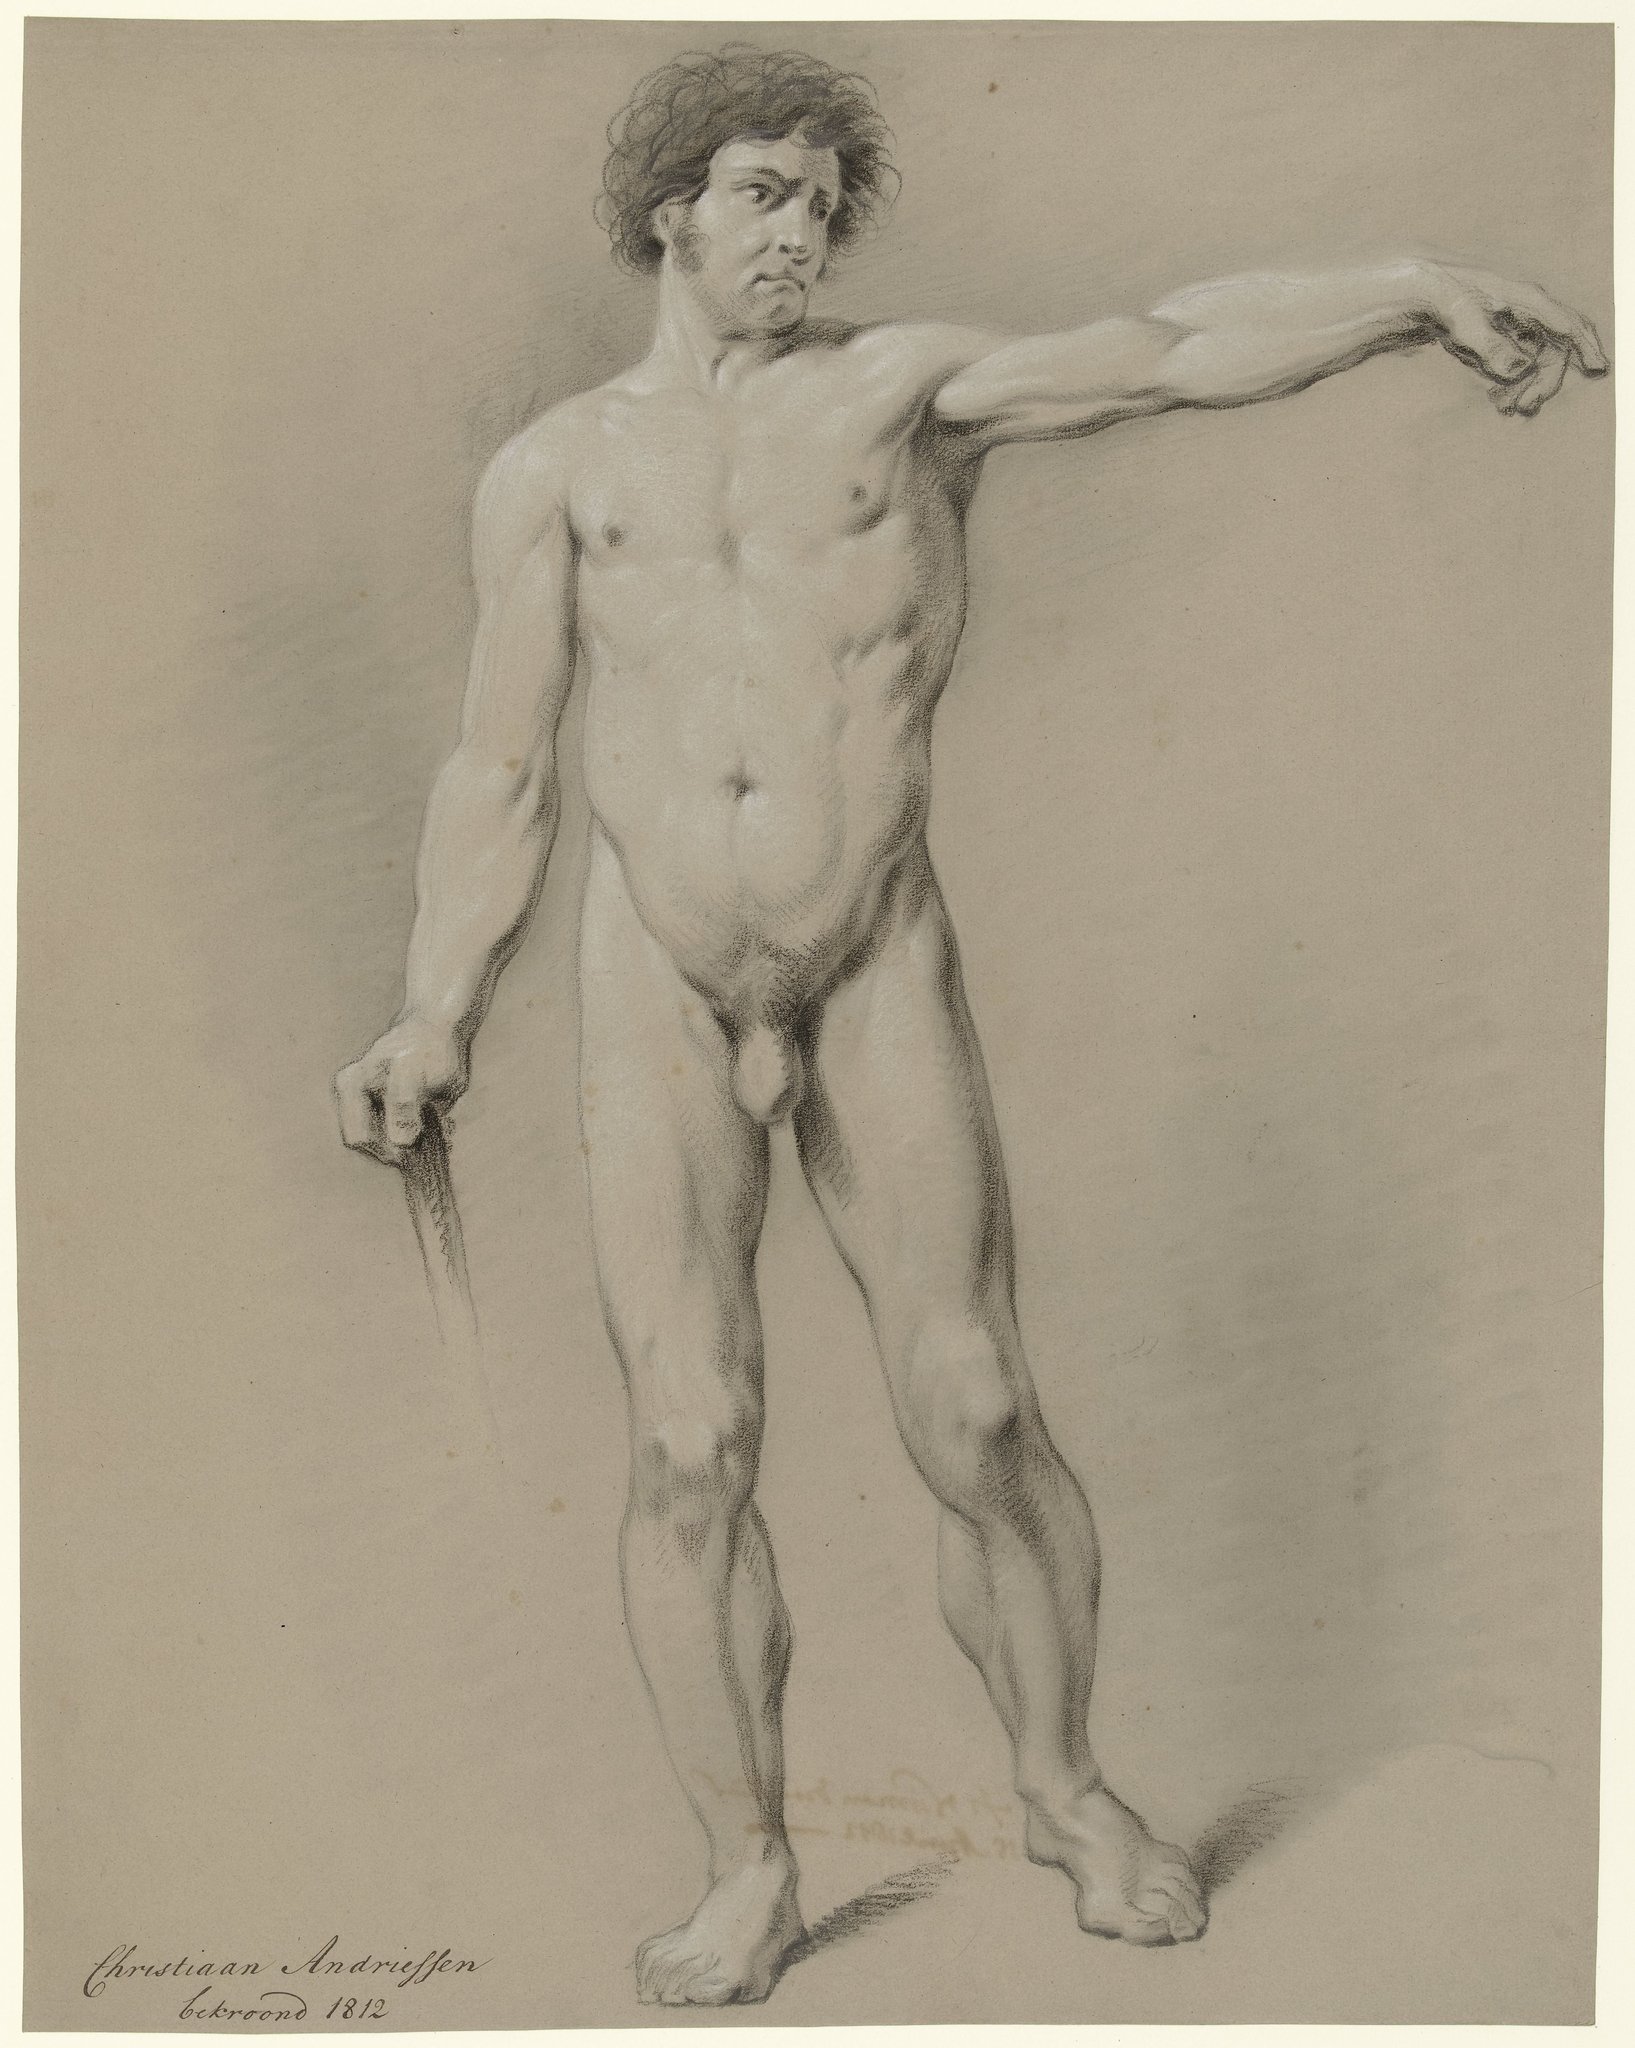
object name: drawing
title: Staand mannelijk naakt, van voren, de linkerarm gestrekt naar links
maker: christiaan andriessen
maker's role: draughtsman, print maker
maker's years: 1775-1846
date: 1812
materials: chalk, paper